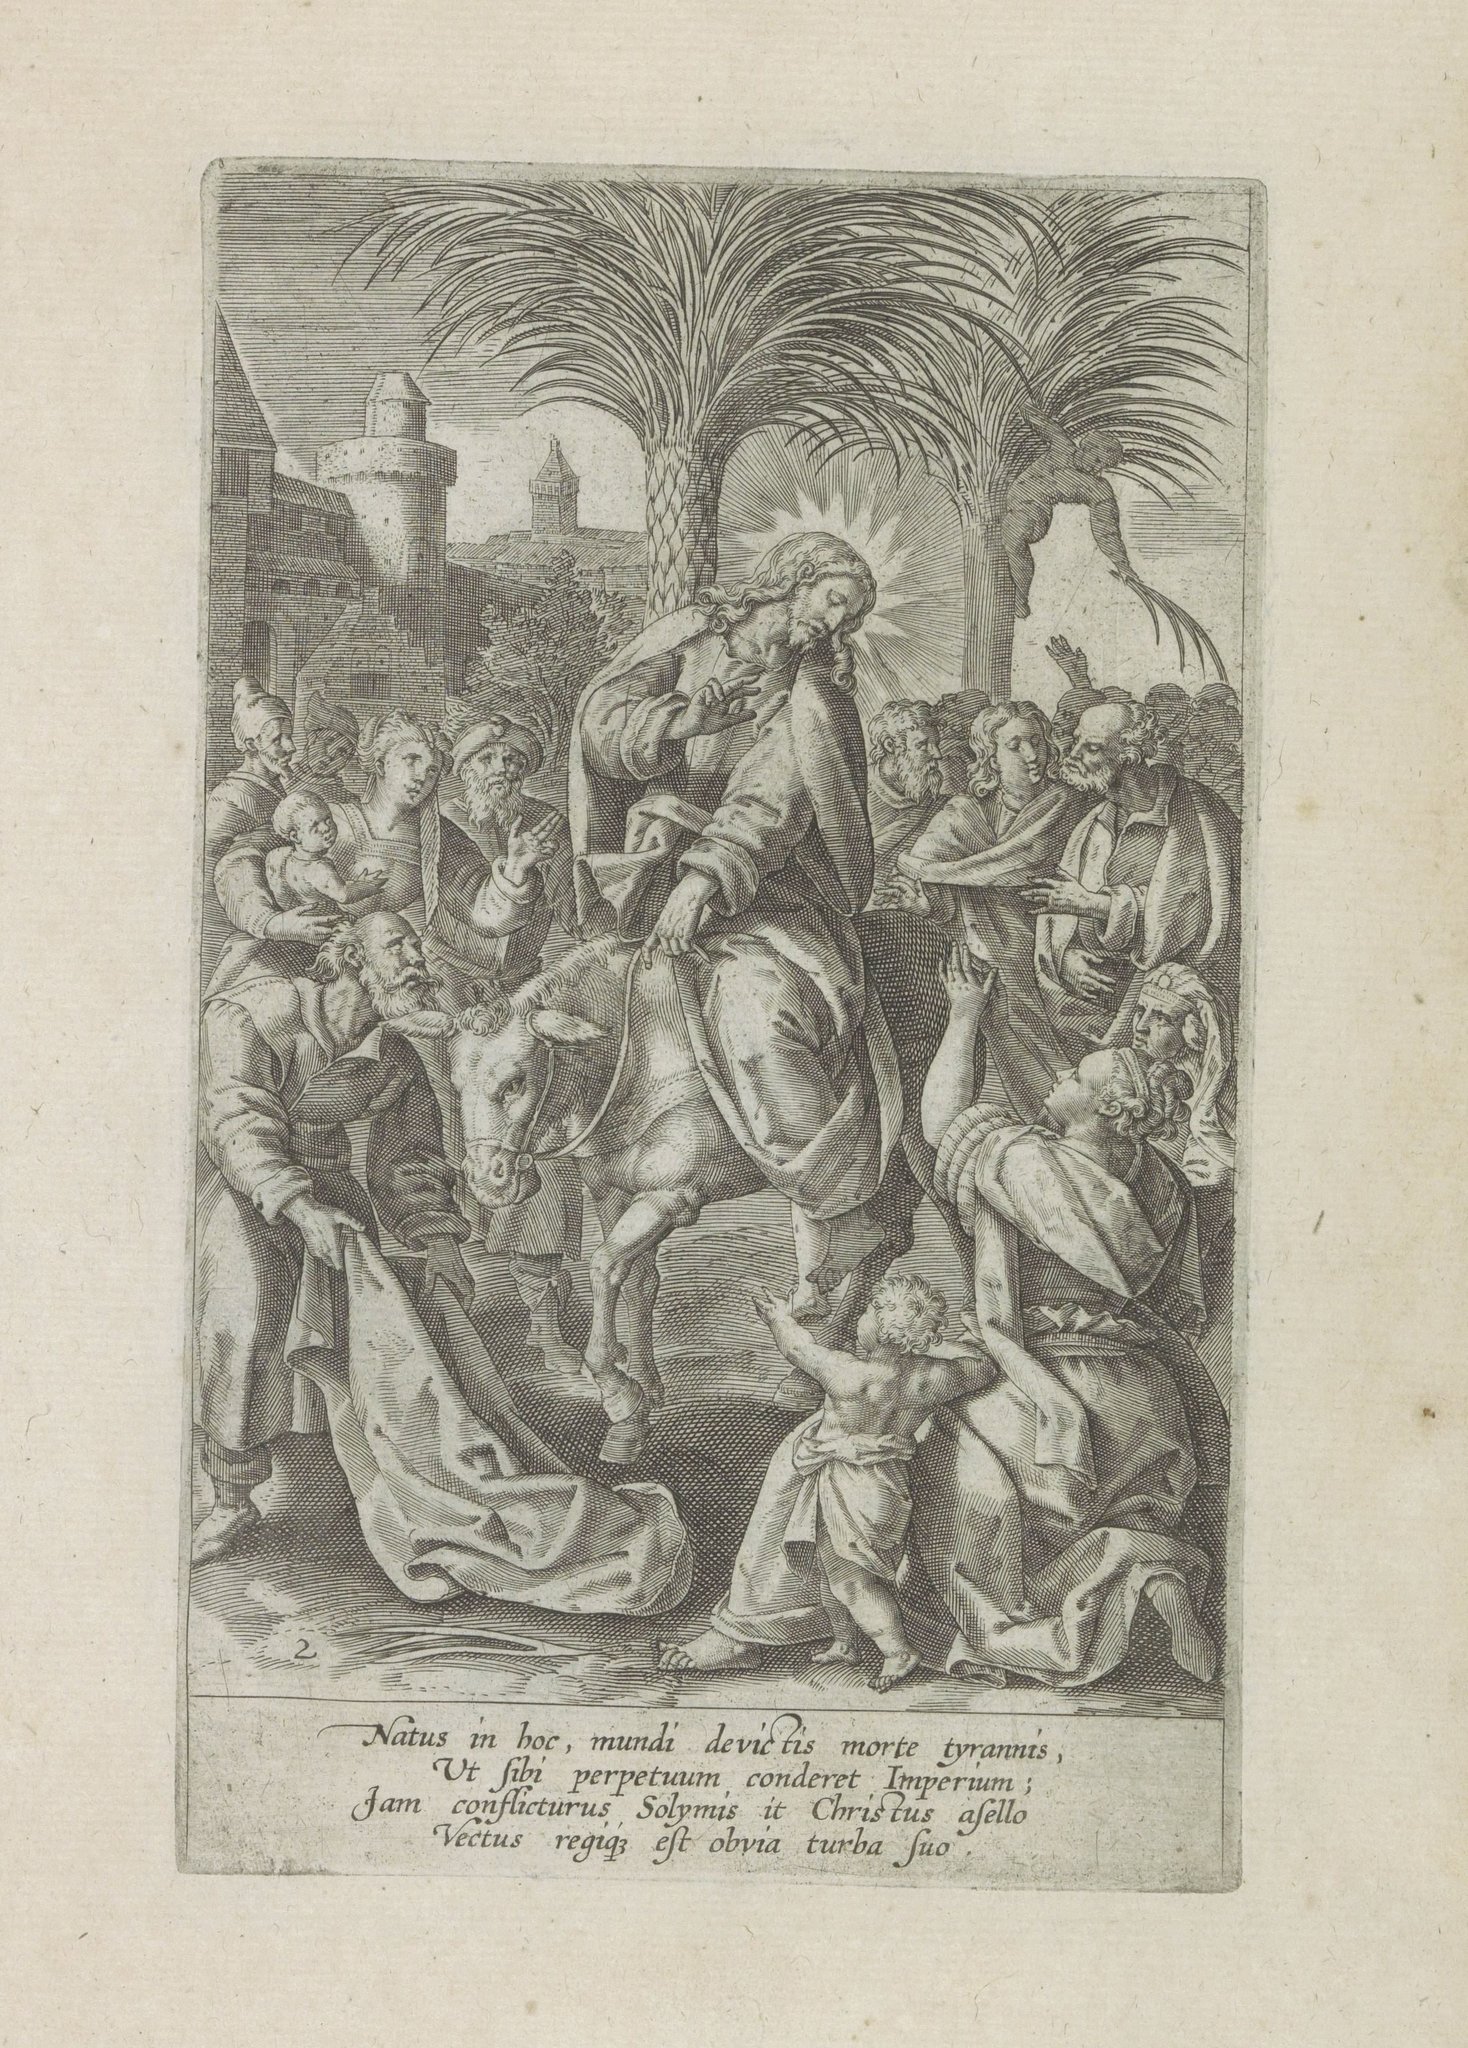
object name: album leaf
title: Intocht van Christus in Jeruzalem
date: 1585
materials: paper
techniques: engraving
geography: antwerp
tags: entry into jerusalem: people spreading their clothes before christ on the ass, and waving palm branches (matthew 21:1-11, 21:14-16; mark 11:1-11; luke 19:28-40; john 12:12-19)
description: Christus rijdt op een ezel Jeruzalem binnen en wordt ontvangen door een menigte mensen die hem eren. Een man spreidt zijn mantel uit op de grond. Op de achtergrond palmbomen. Onder de voorstelling een vierregelig vers in het Latijn. Deze prent maakt deel uit van een album.